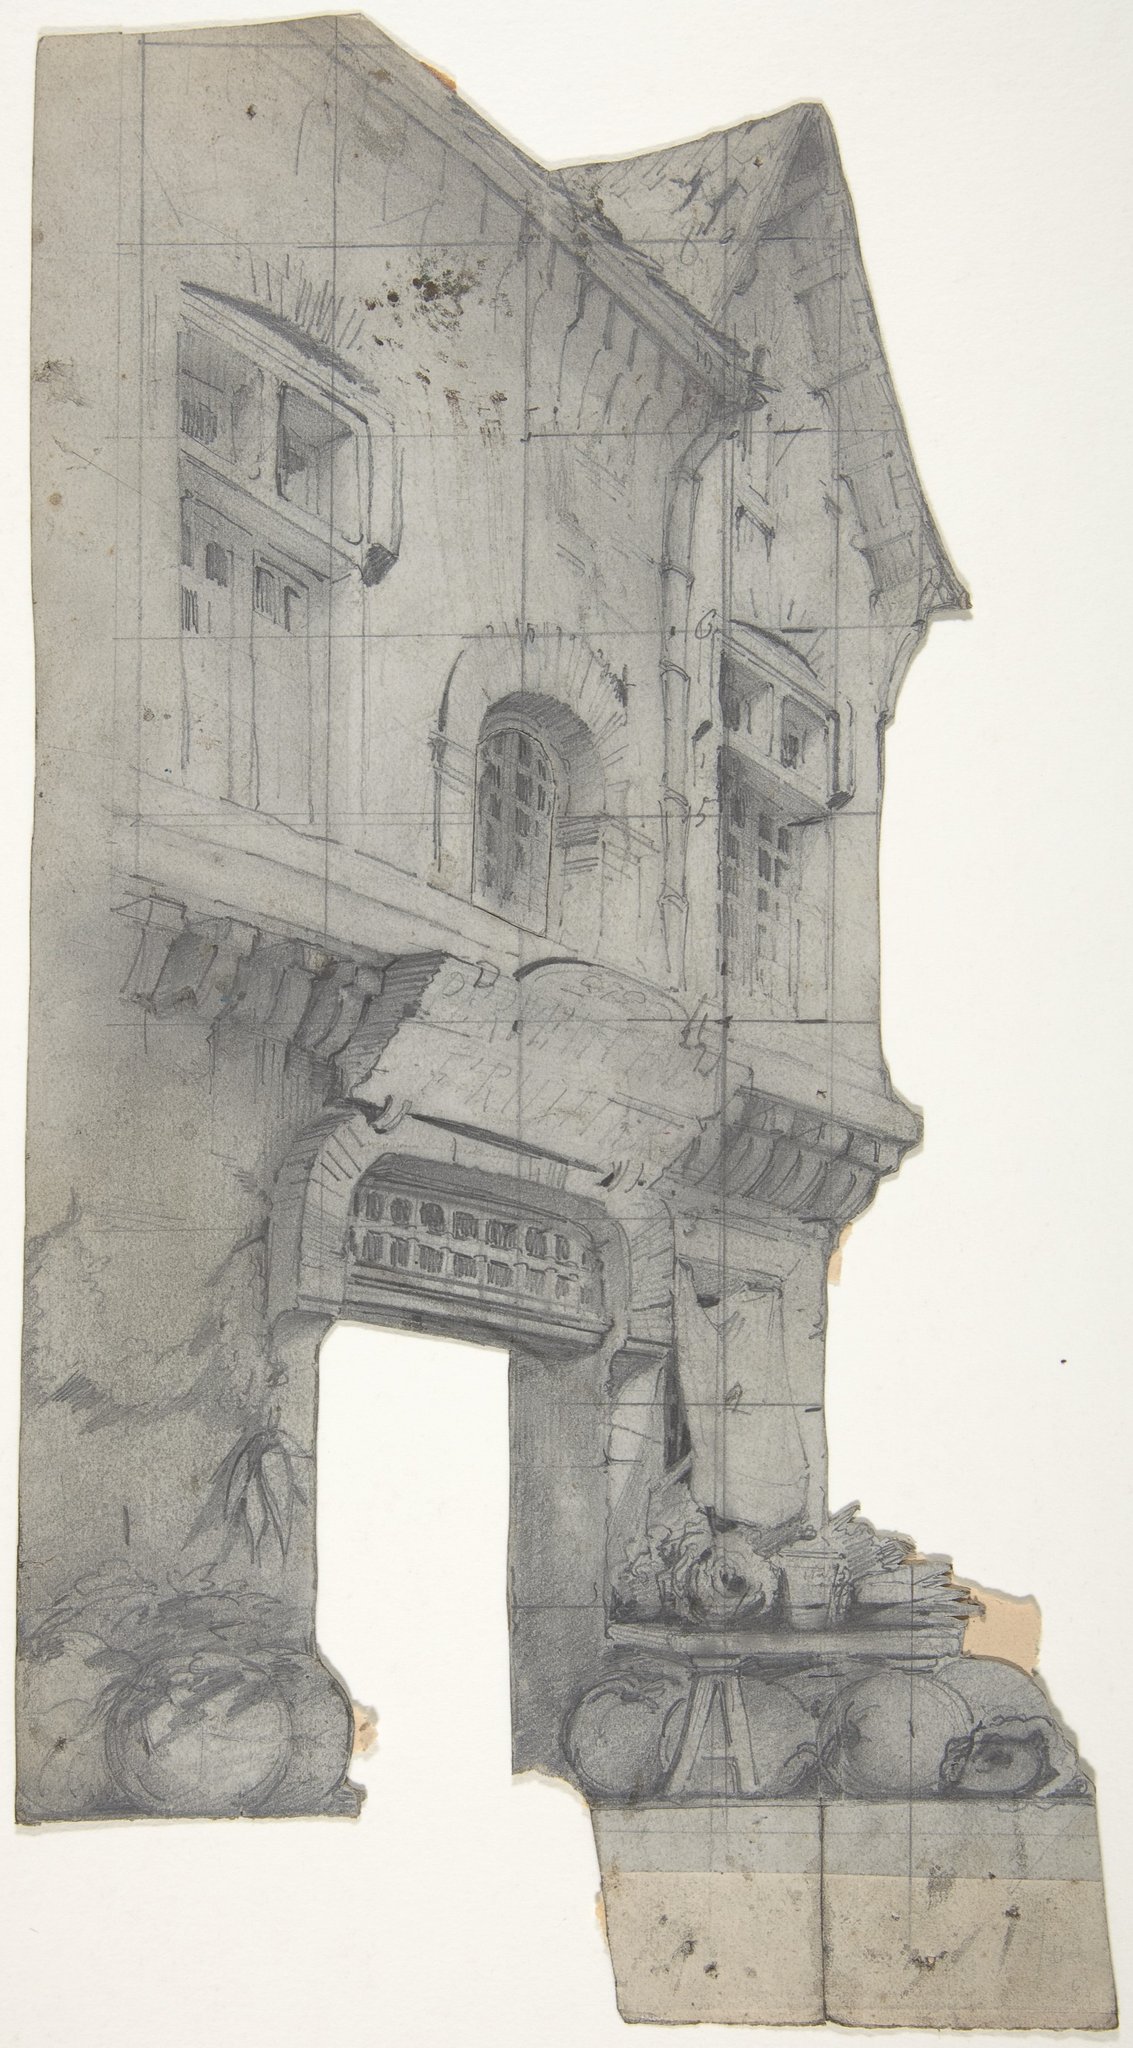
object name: drawing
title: Design for a Stage Set at the Opéra, Paris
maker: eugène cicéri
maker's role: artist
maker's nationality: french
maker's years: 1813-1890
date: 1830-1890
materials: graphite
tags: buildings,stage design